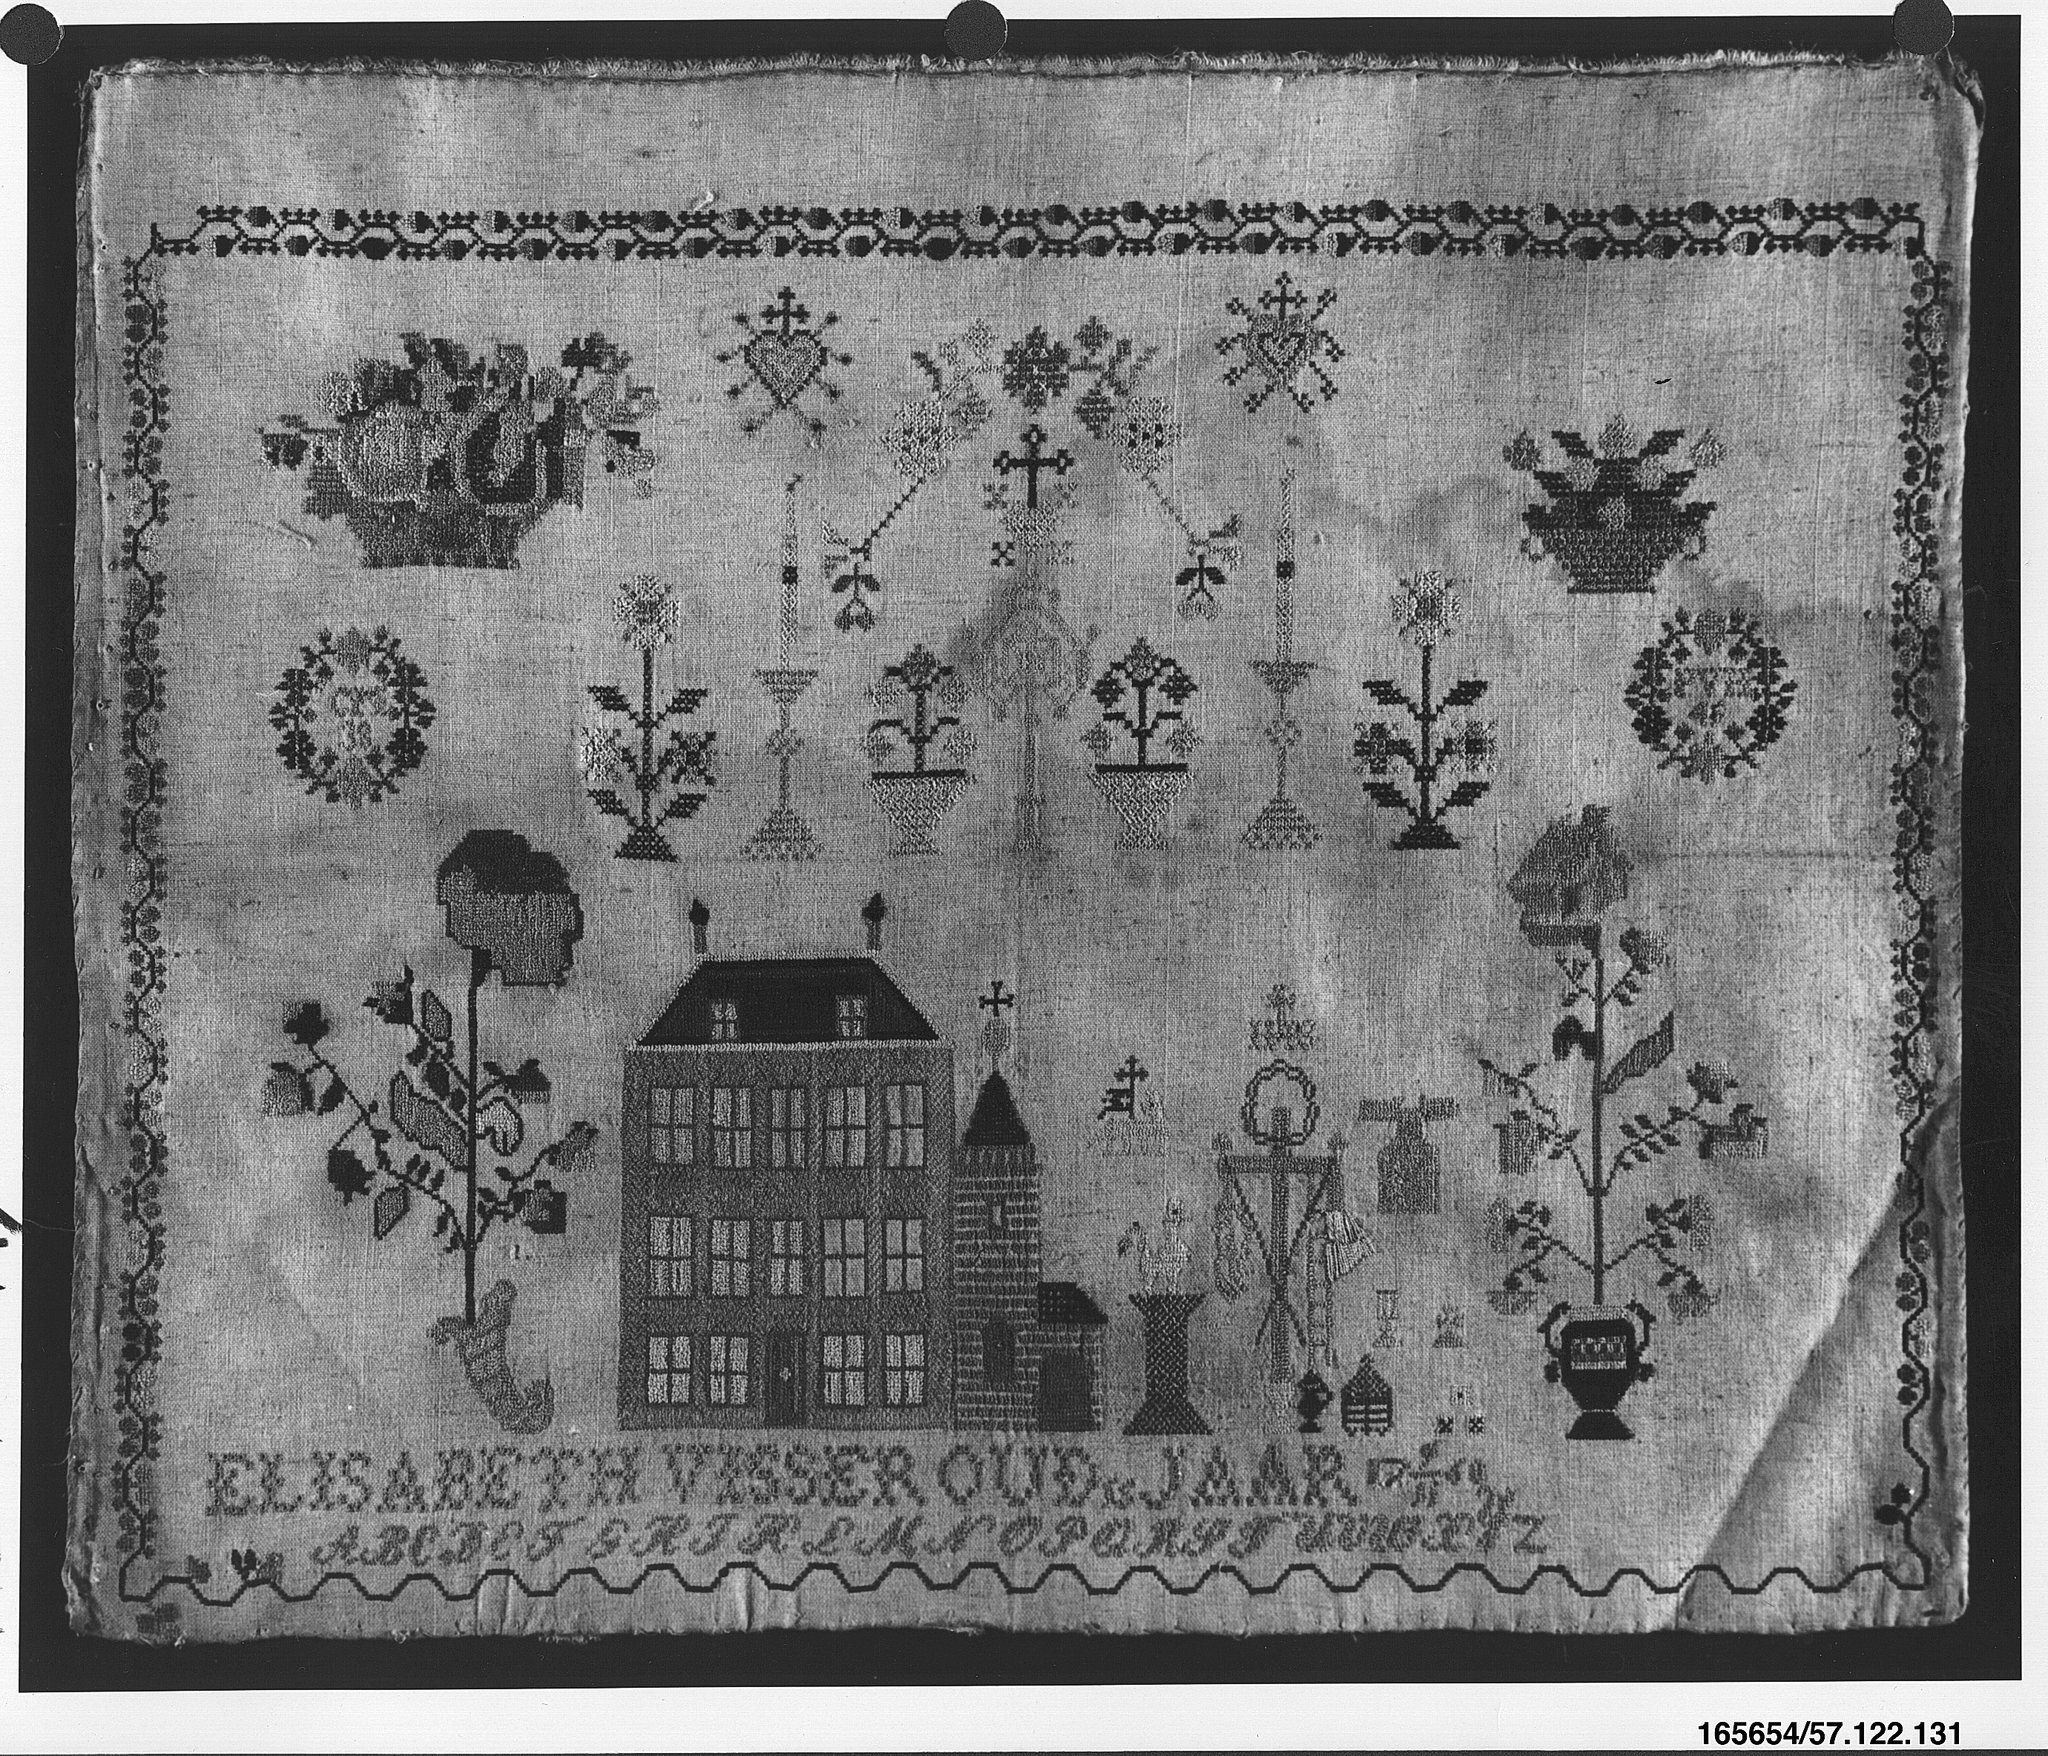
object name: sampler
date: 1760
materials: linen, silk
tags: houses,garlands